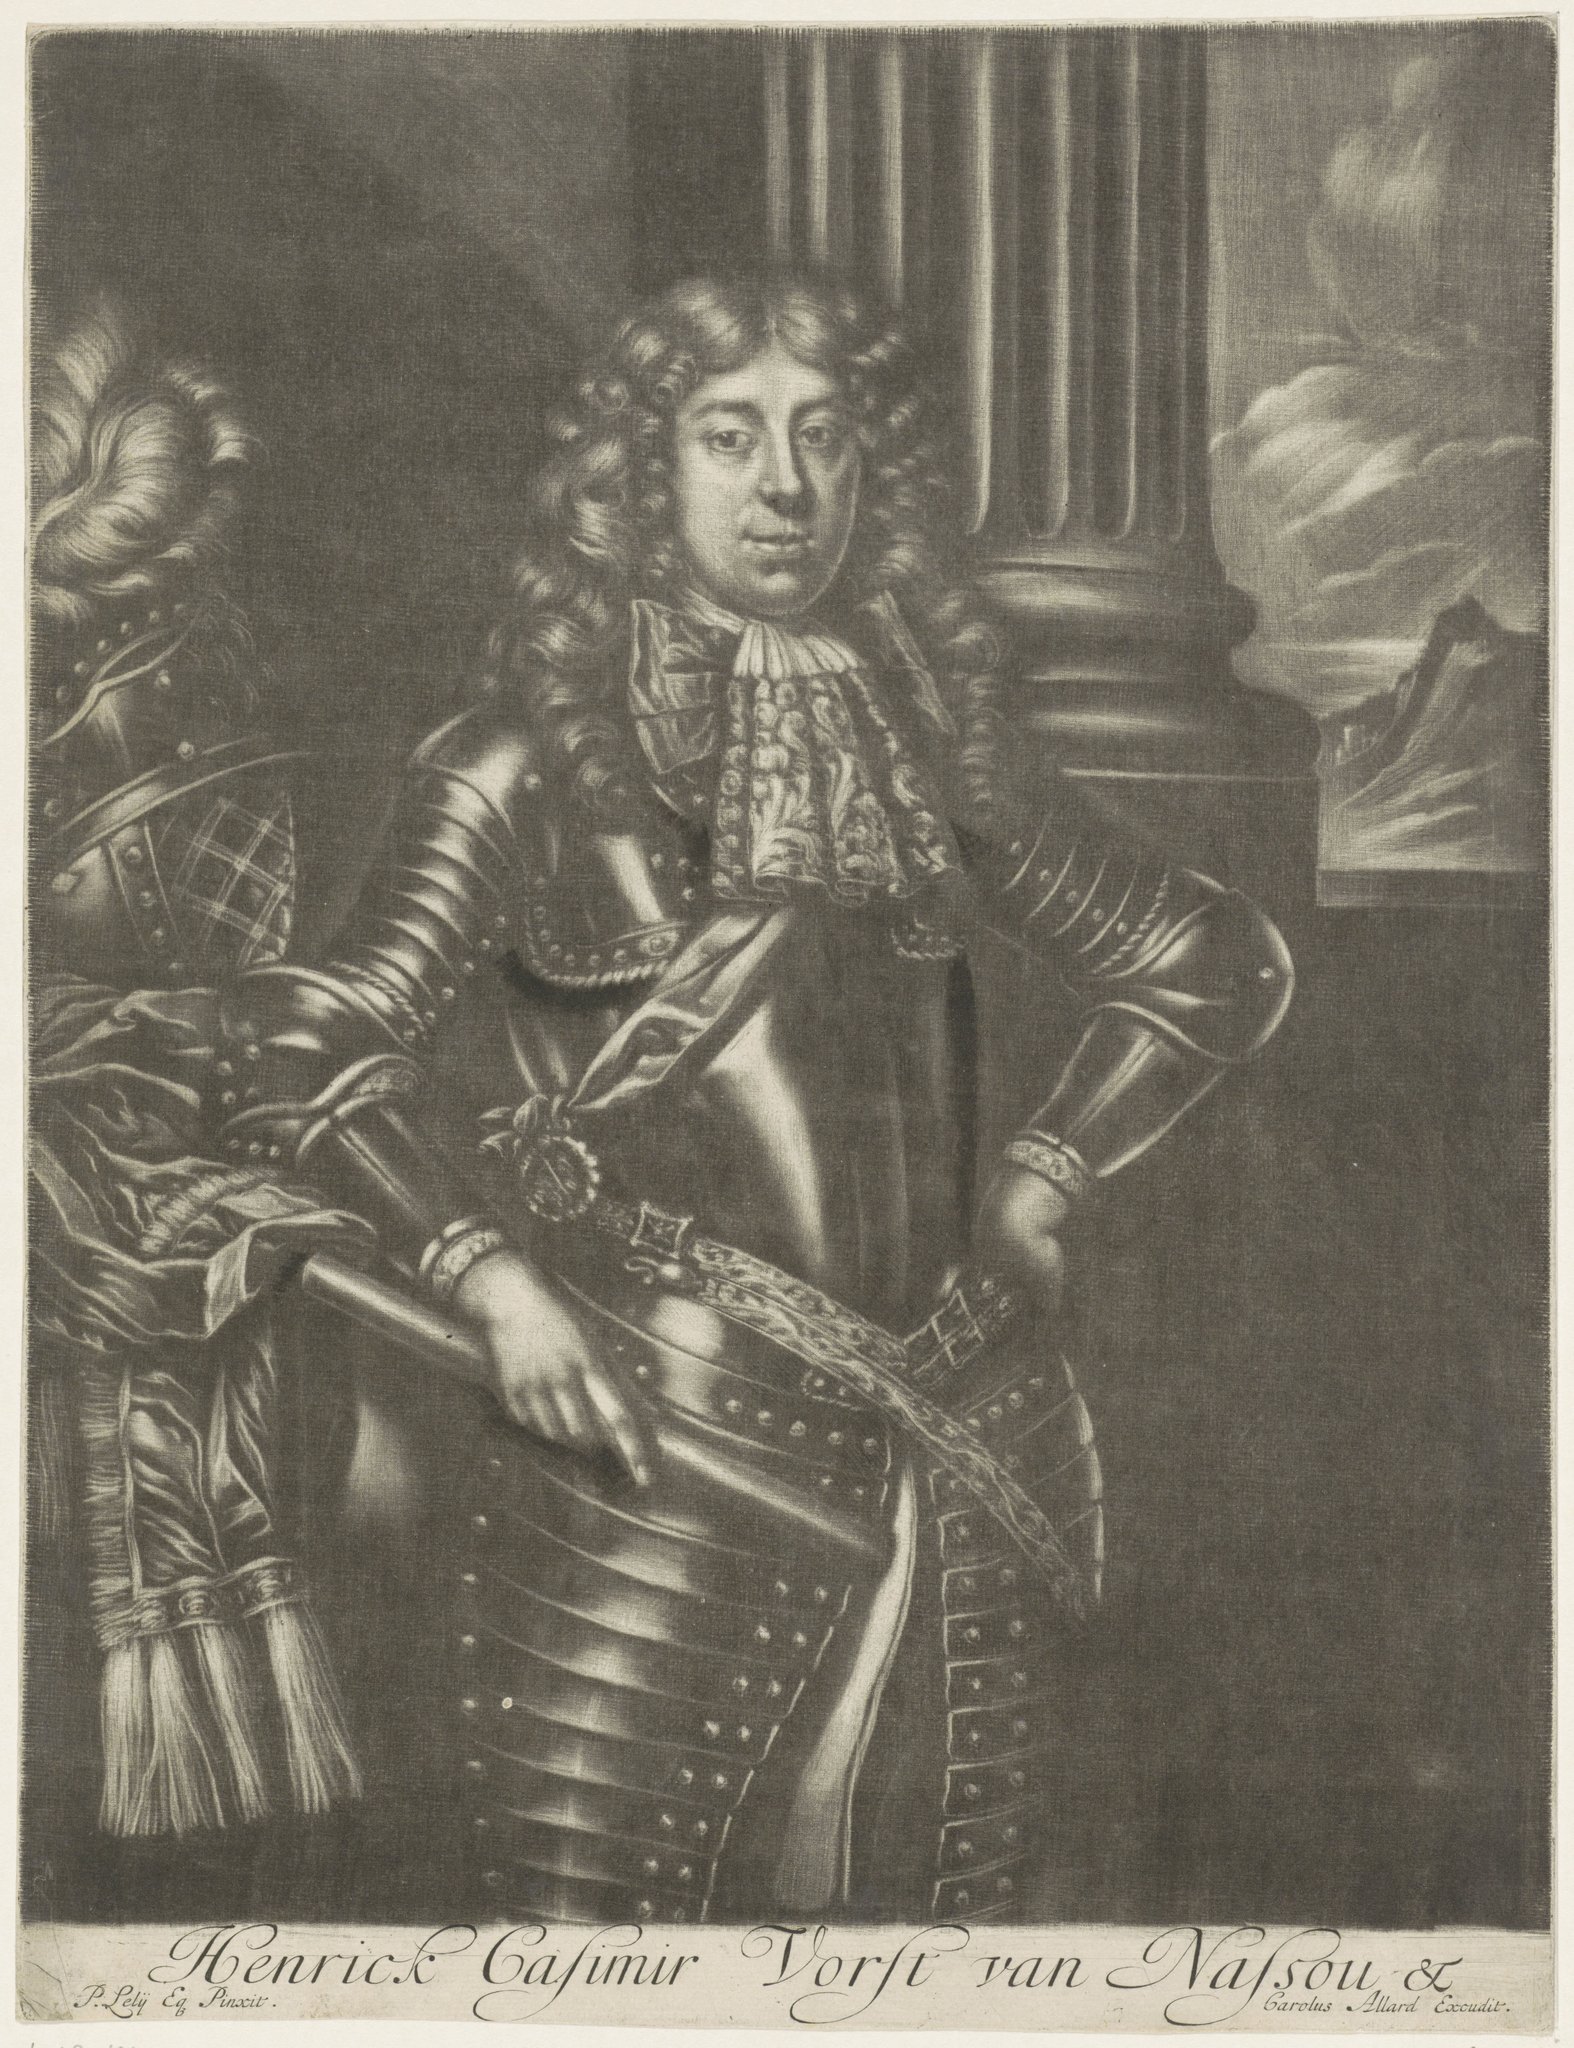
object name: print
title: Maria en het slapende Christuskind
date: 1655-1700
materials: paper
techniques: mezzotint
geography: amsterdam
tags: madonna: i.e. mary with the christ-child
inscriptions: collector's mark: Lugt 2228